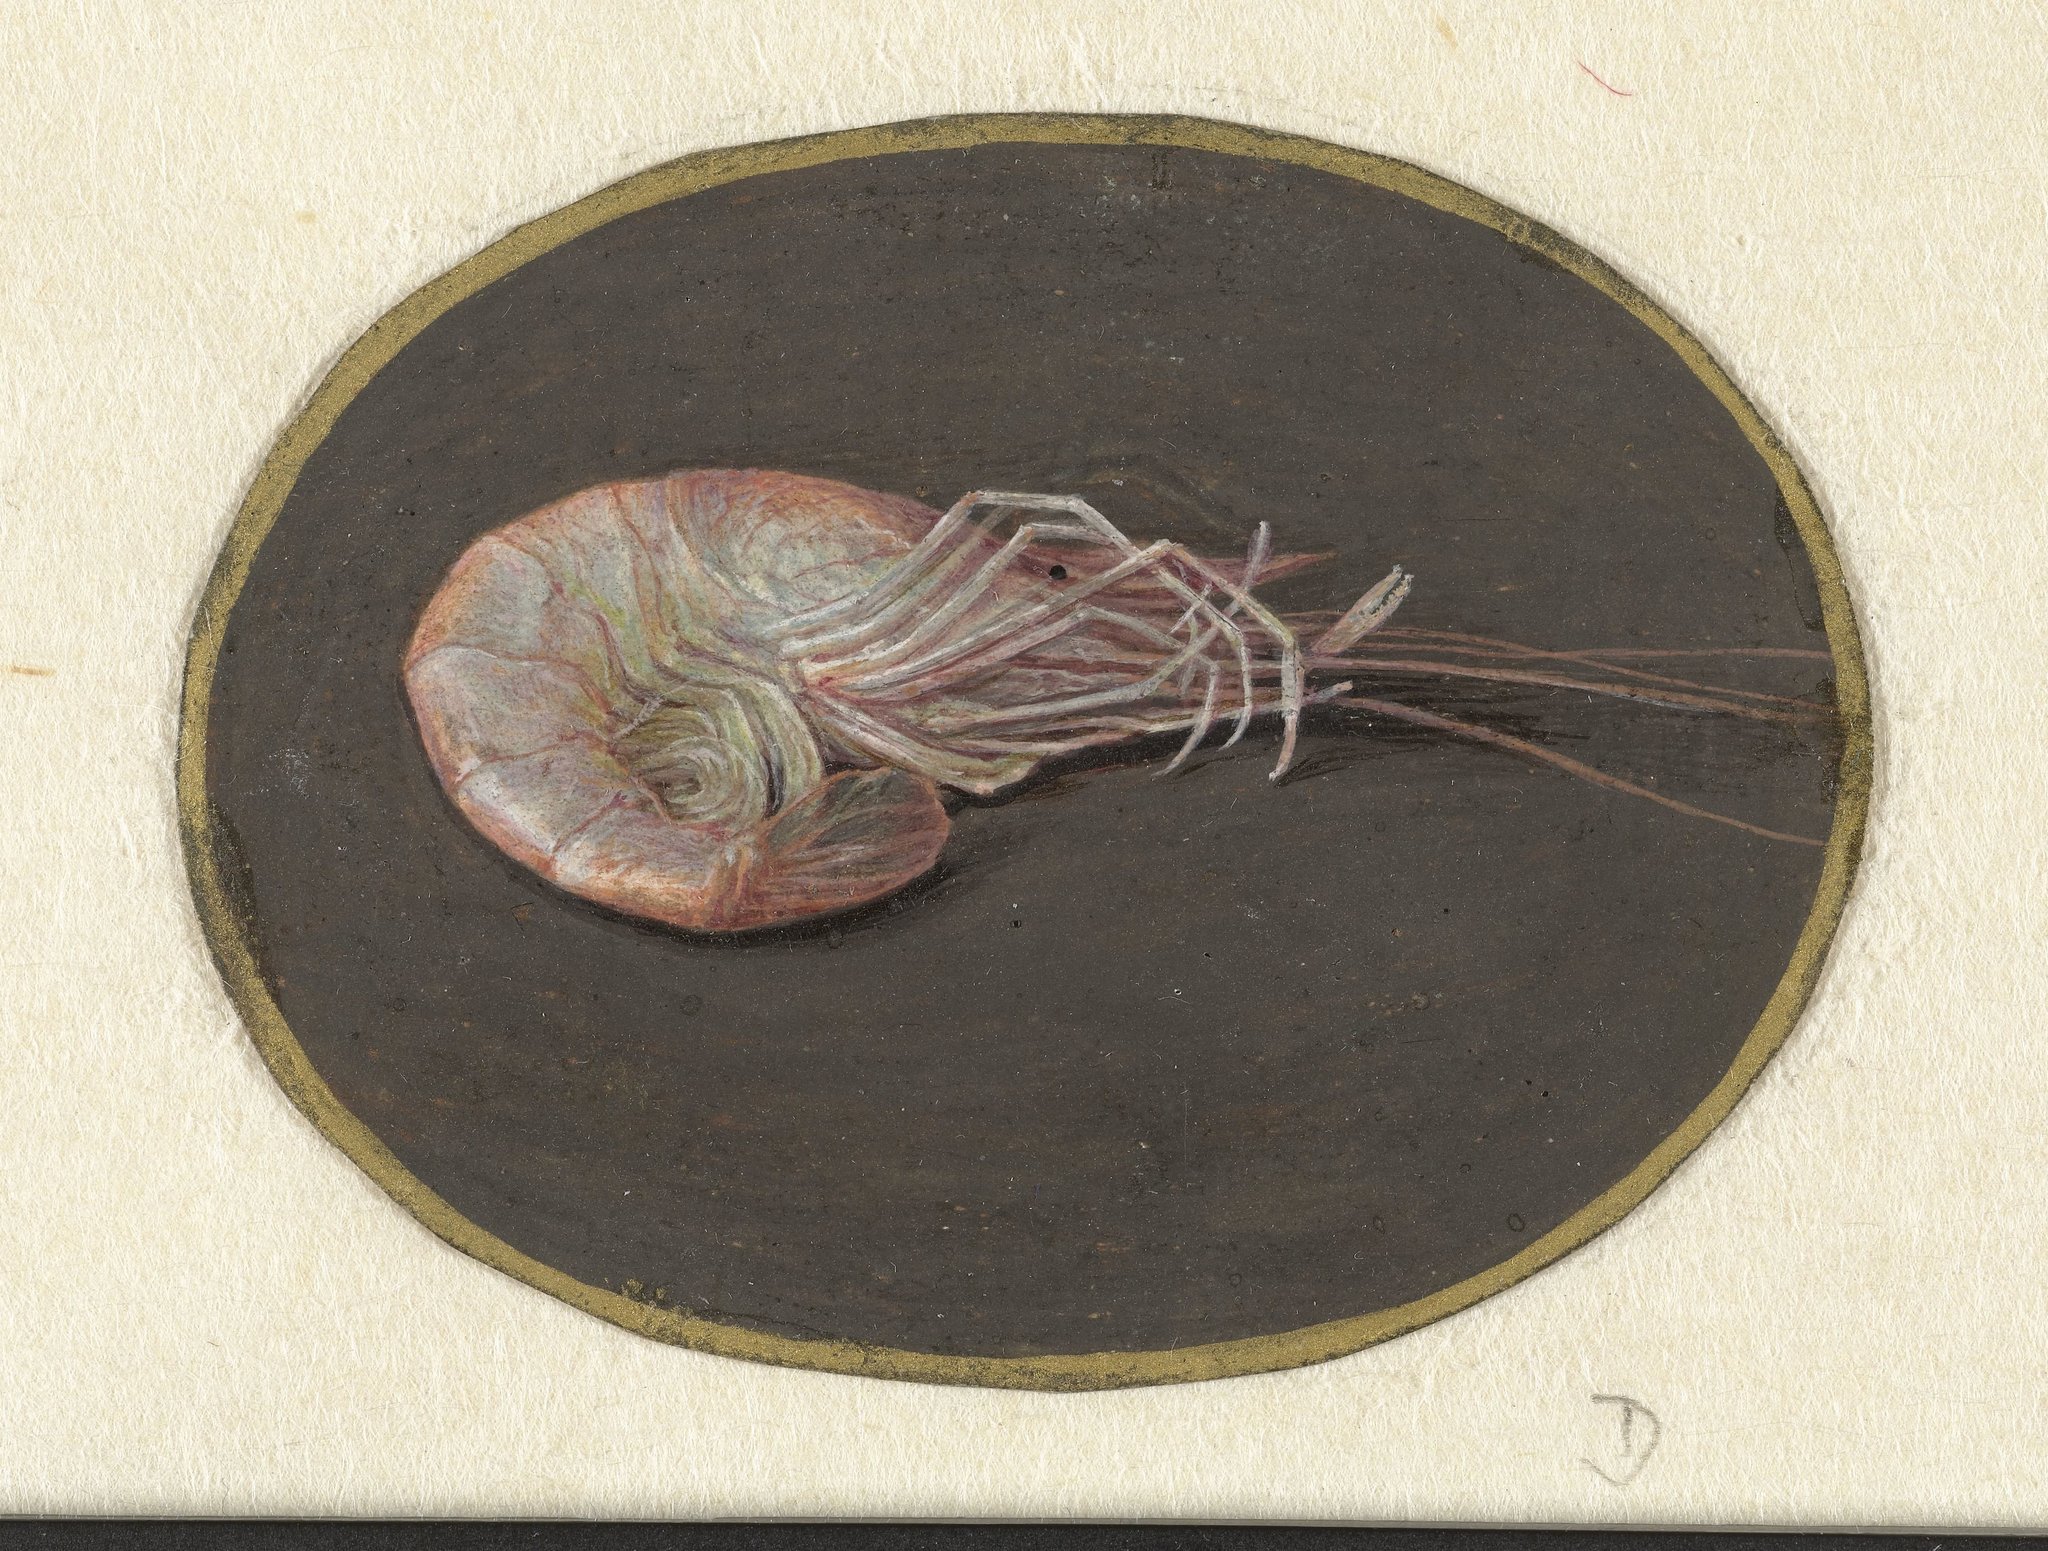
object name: drawing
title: Dieren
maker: jan augustin van der goes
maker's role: draughtsman, painter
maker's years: 1671-1697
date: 1690-1700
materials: paint, gouache, parchment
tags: crustaceans: shrimp